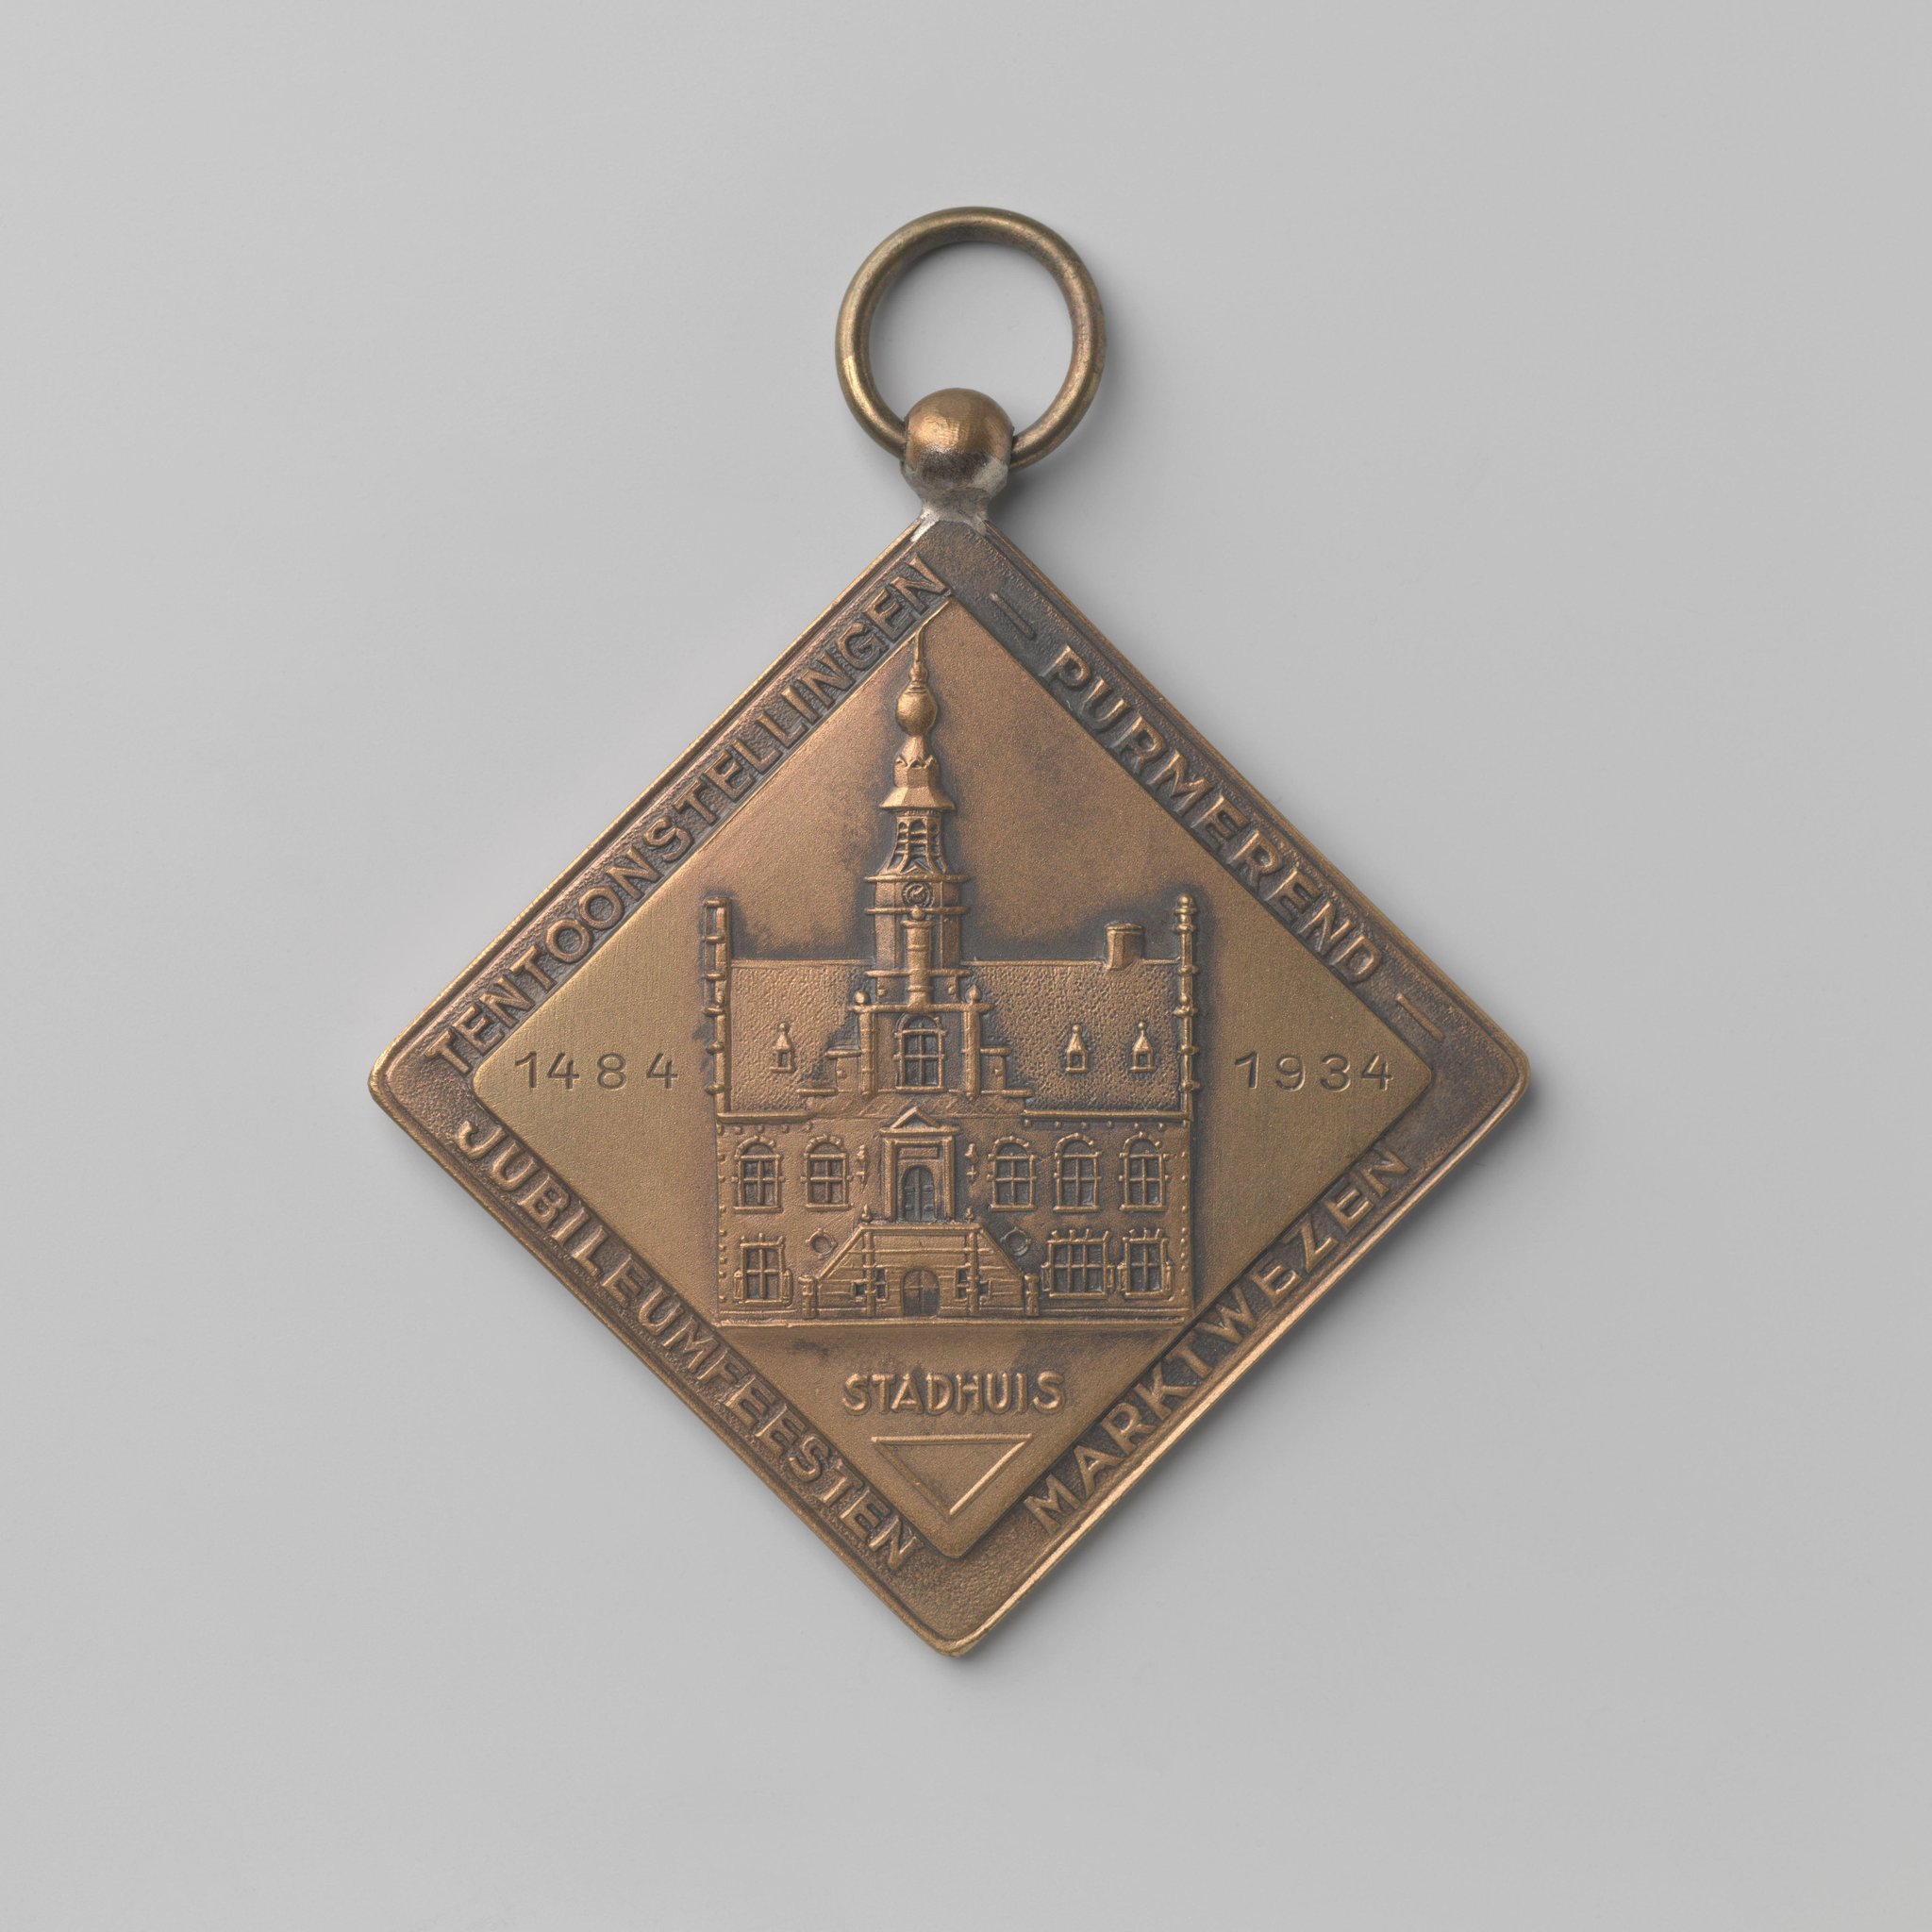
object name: history medal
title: Vierhonderdvijftigjarig bestaan van Purmerend als stad 1934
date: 1934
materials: bronze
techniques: striking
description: Ruitvormige bronzen penning met bal en draagoog, op de voorzijde het stadhuis van Purmerend tussen twee jaartallen, met omschrift, op de keerzijde een inscriptieruimte waarboven het gekroonde wapenschild van Purmerend op een tekstlint.